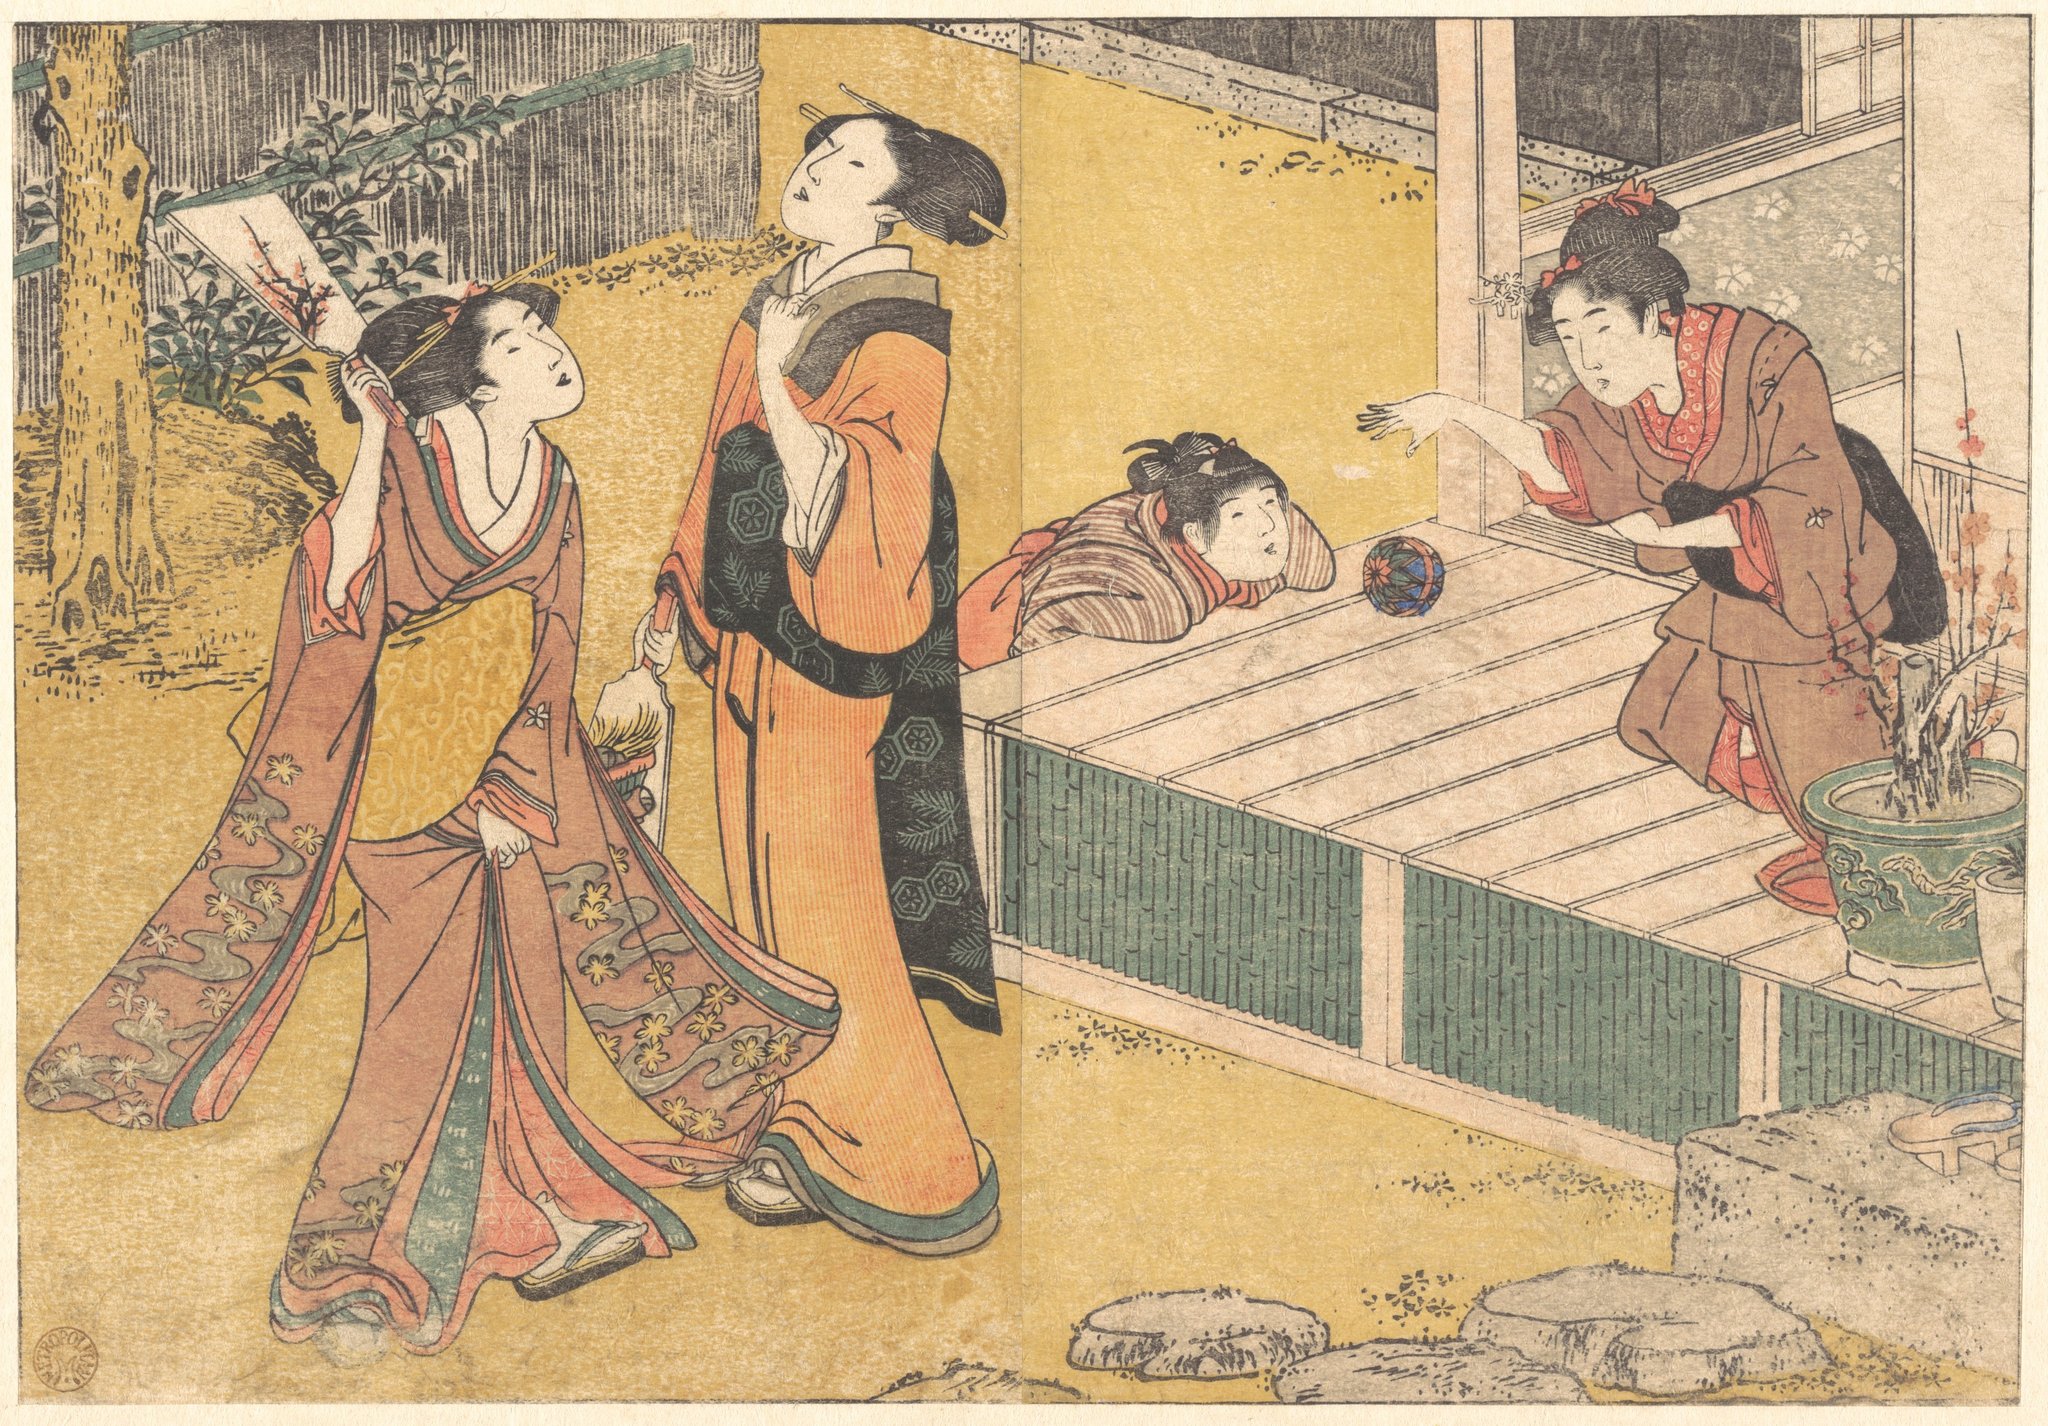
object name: woodblock print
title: New Year's Games, from the printed book Flowers of the Four Seasons (Shiki no hana)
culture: japanese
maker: kitagawa utamaro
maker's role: artist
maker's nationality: japanese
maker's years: 1754-1806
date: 1801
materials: ink, paper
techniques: woodblock print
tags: women,playing